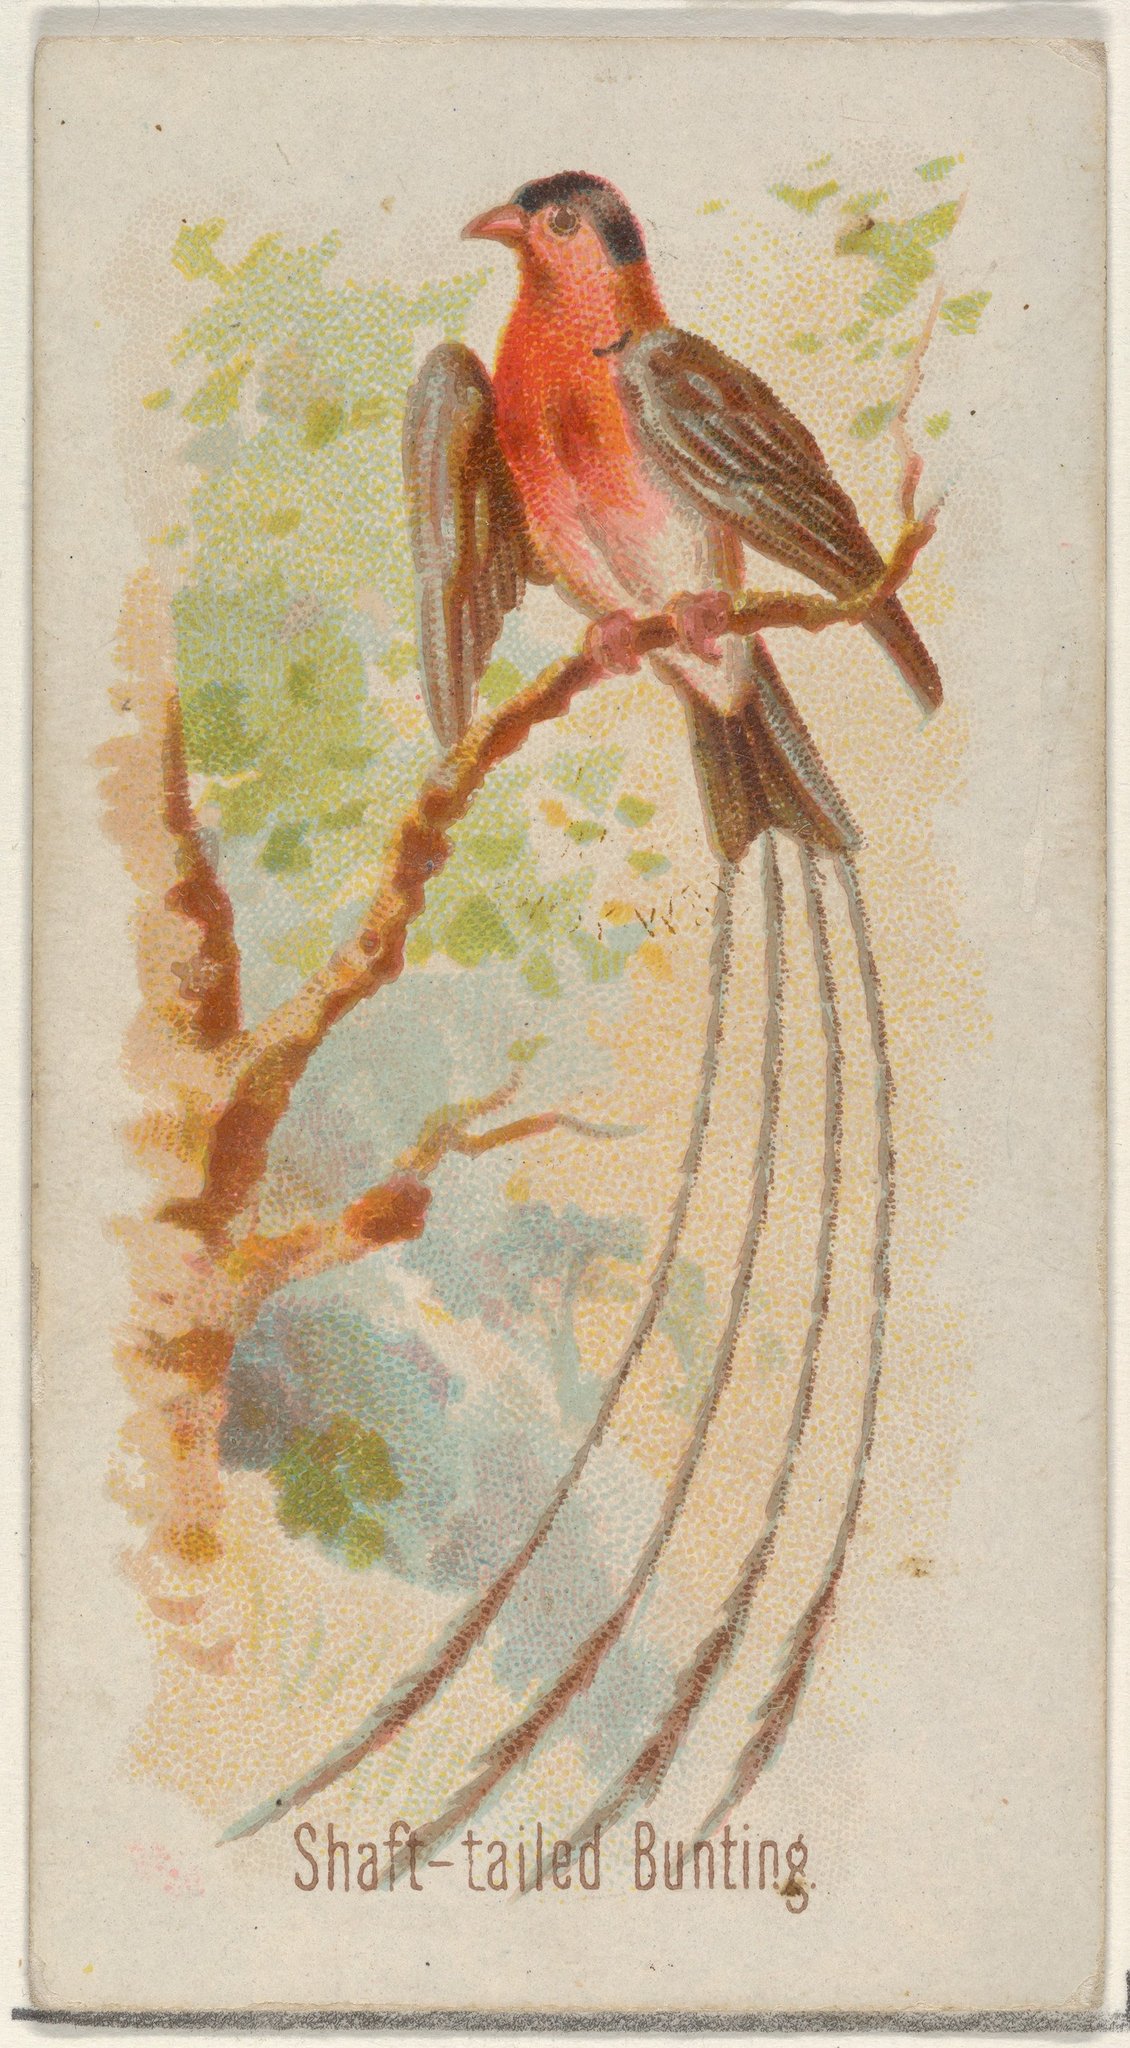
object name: print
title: Shaft-tailed Bunting, from the Song Birds of the World series (N23) for Allen & Ginter Cigarettes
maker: allen & ginter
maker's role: publisher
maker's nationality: american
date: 1890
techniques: color lithograph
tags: birds